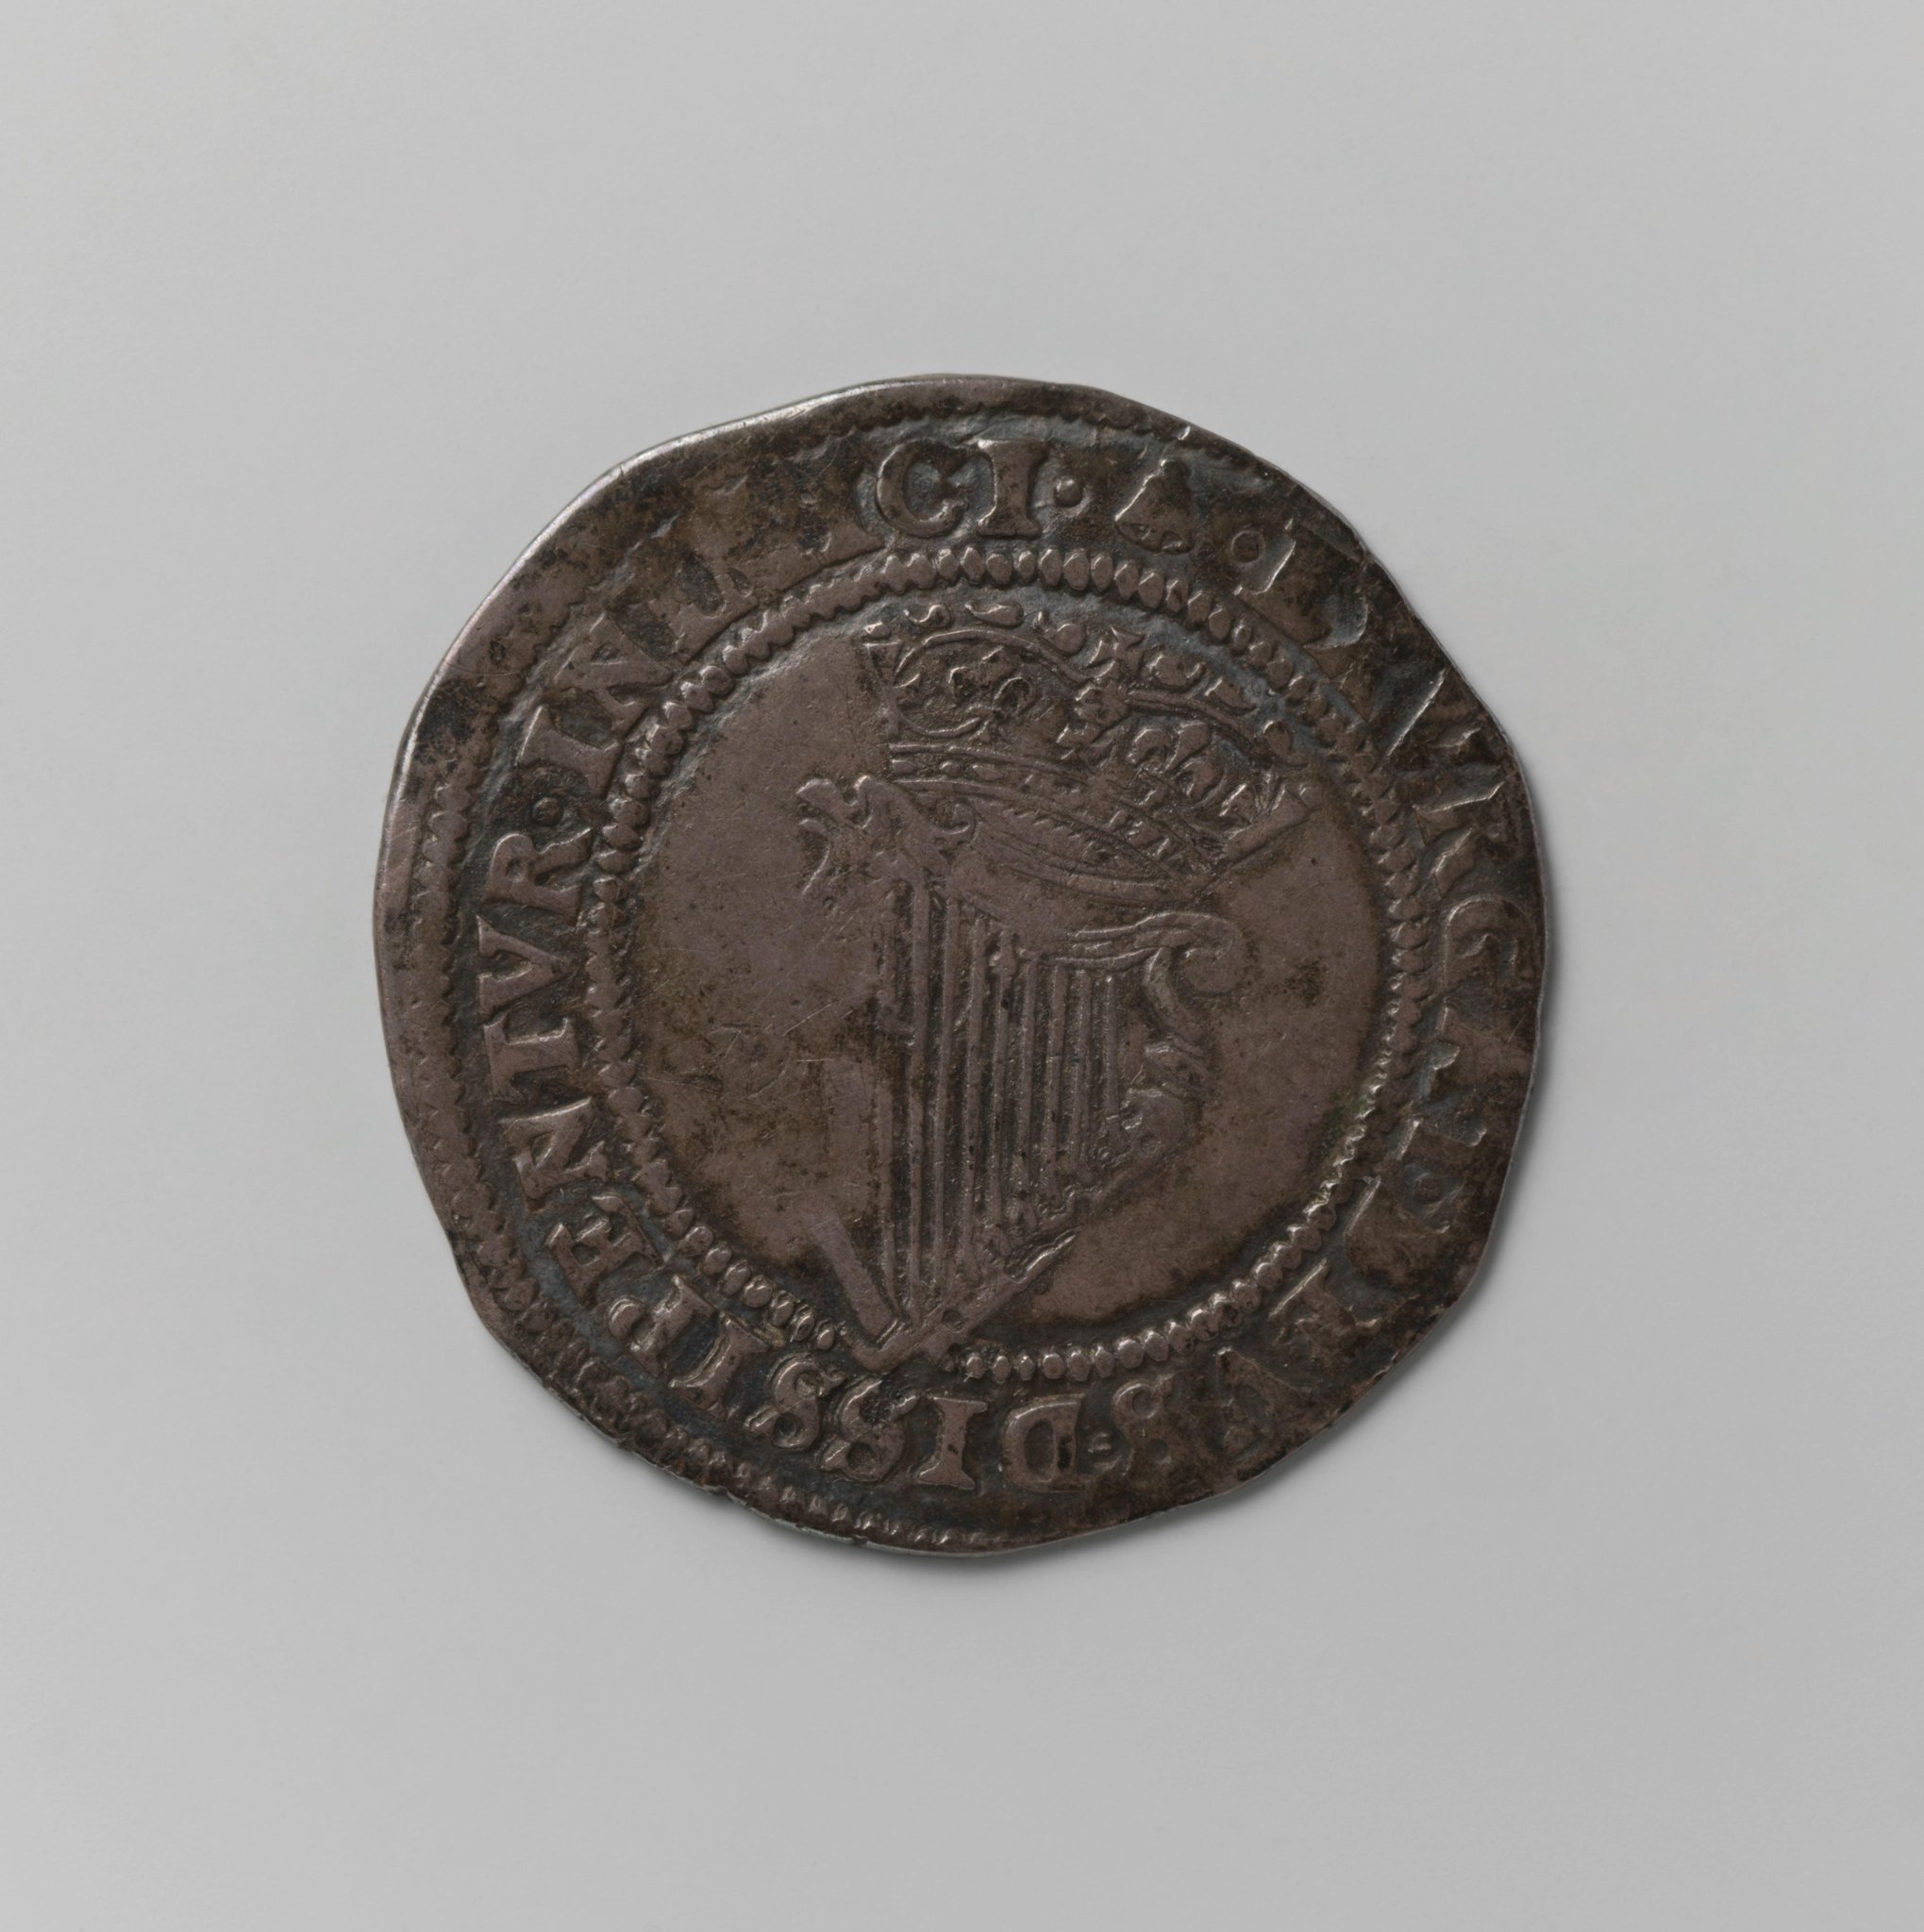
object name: coin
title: Ierland, Jacobus I, 6 pence, [1603]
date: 1603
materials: silver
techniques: striking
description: Zilveren munt. Voorzijde: gekroond borstbeeld naar rechts. Keerzijde: gekroonde harp.